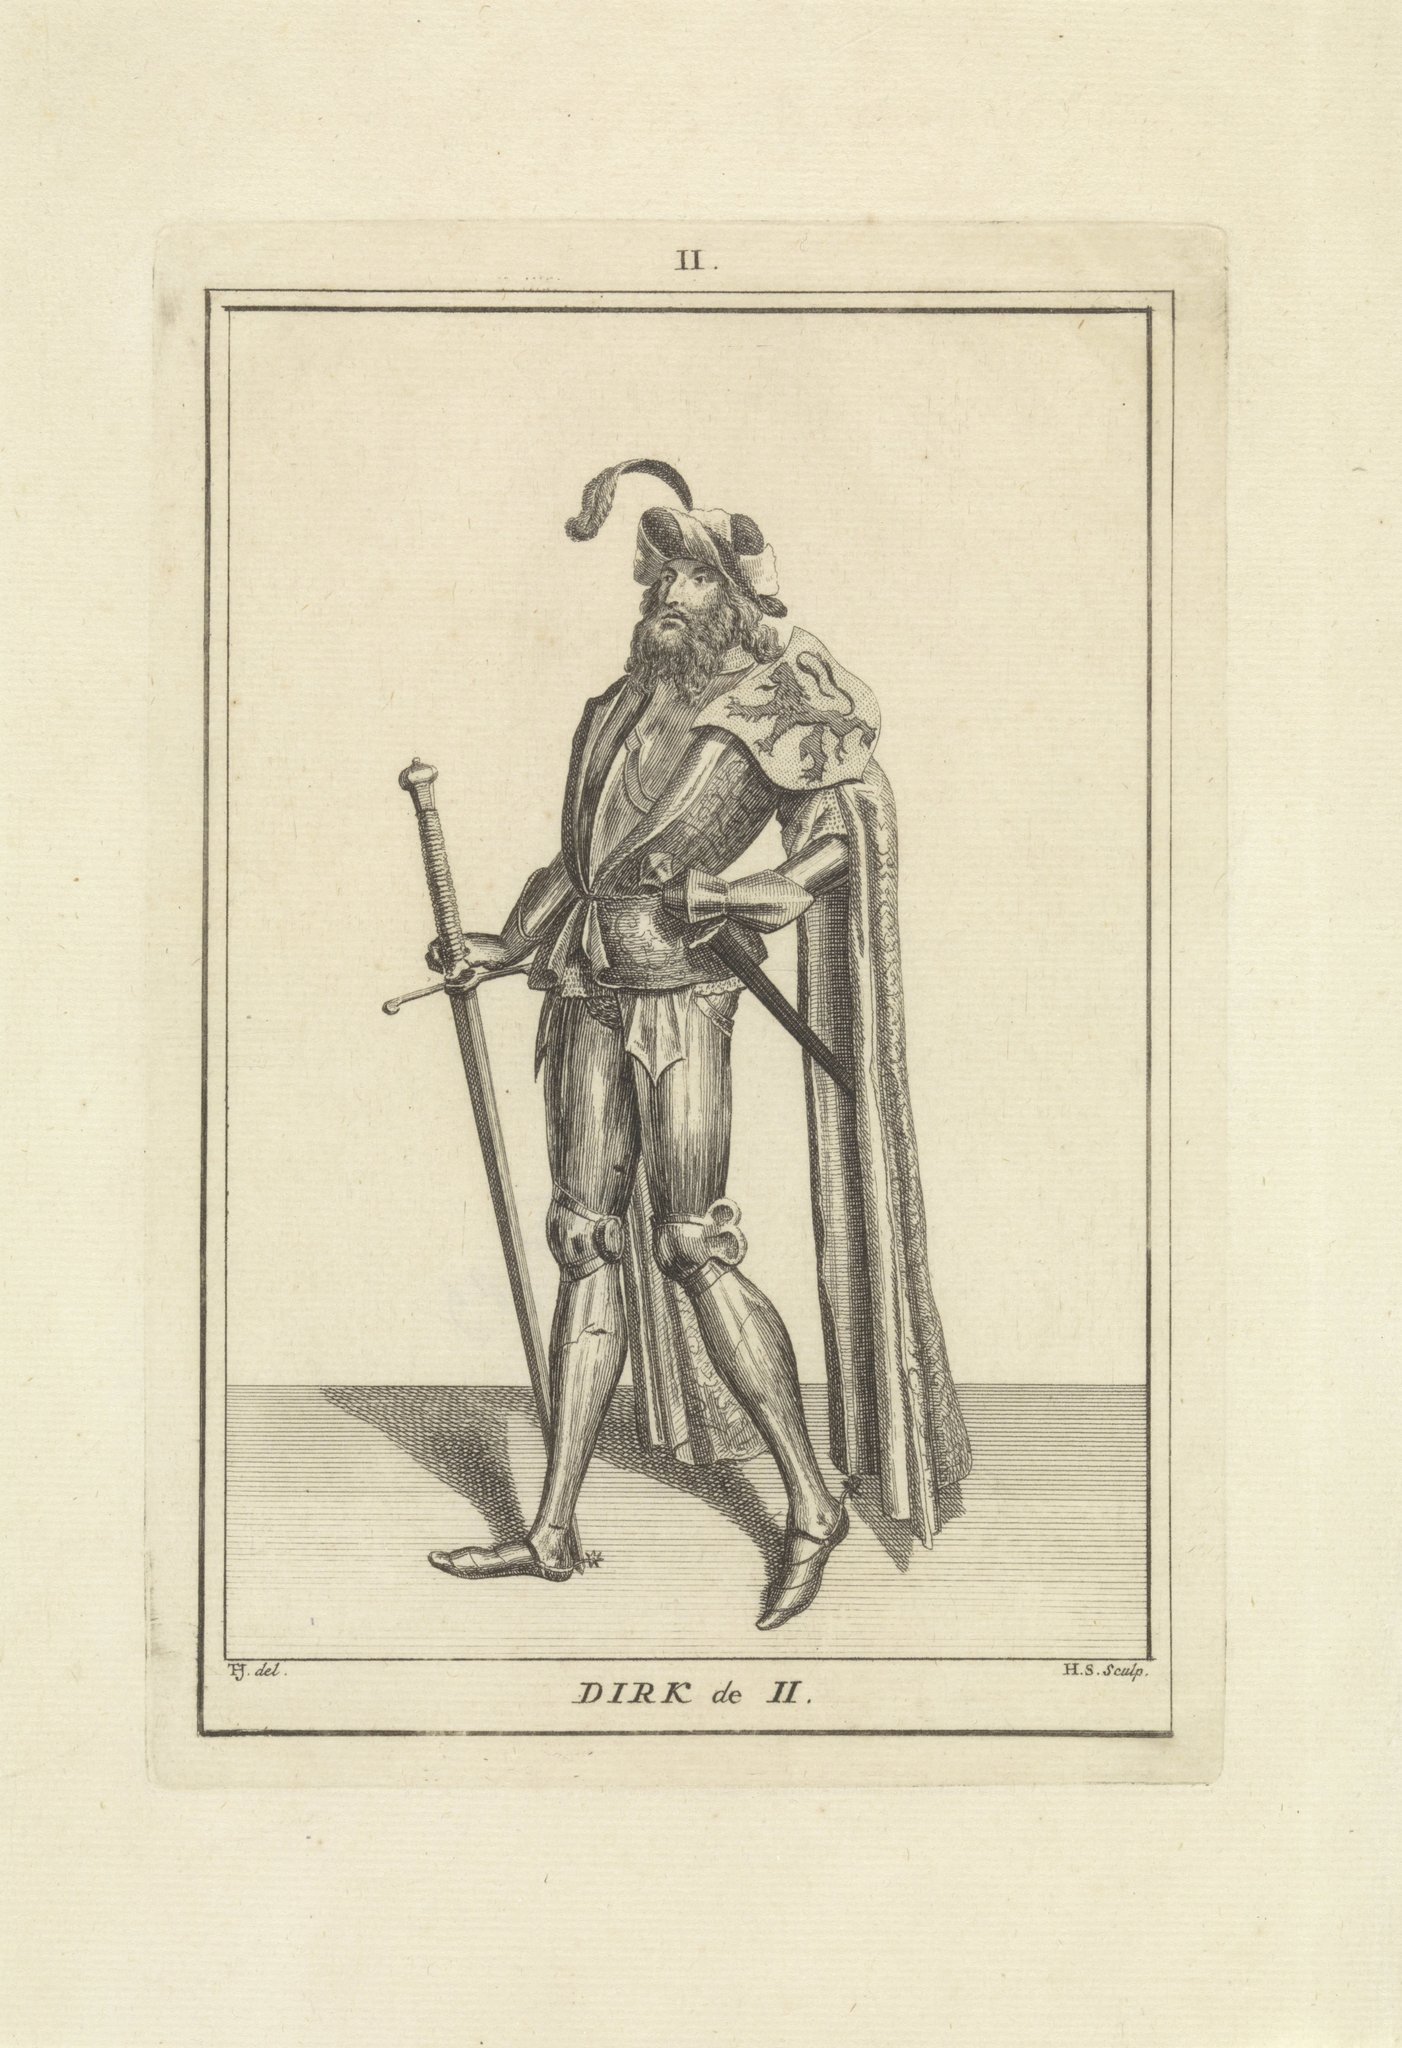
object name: book illustration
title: Portret van Dirk II, graaf van Holland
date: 1745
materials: paper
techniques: etching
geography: haarlem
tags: nobility and patriciate; chivalry, knighthood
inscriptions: collector's mark: Lugt 2228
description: Boekillustratie voor: Langendyk, Pieter. De Graaven van Holland, in jaardichten beschreven door Pieter Langendyk. Verykt met alle de beeldtenissen dier prinsen, naauwkeurig getekend naar de echte aloude tafereelen of de zaal van't raadhuis der stad Haarlem. Haarlem: J. Bosch, 1745.